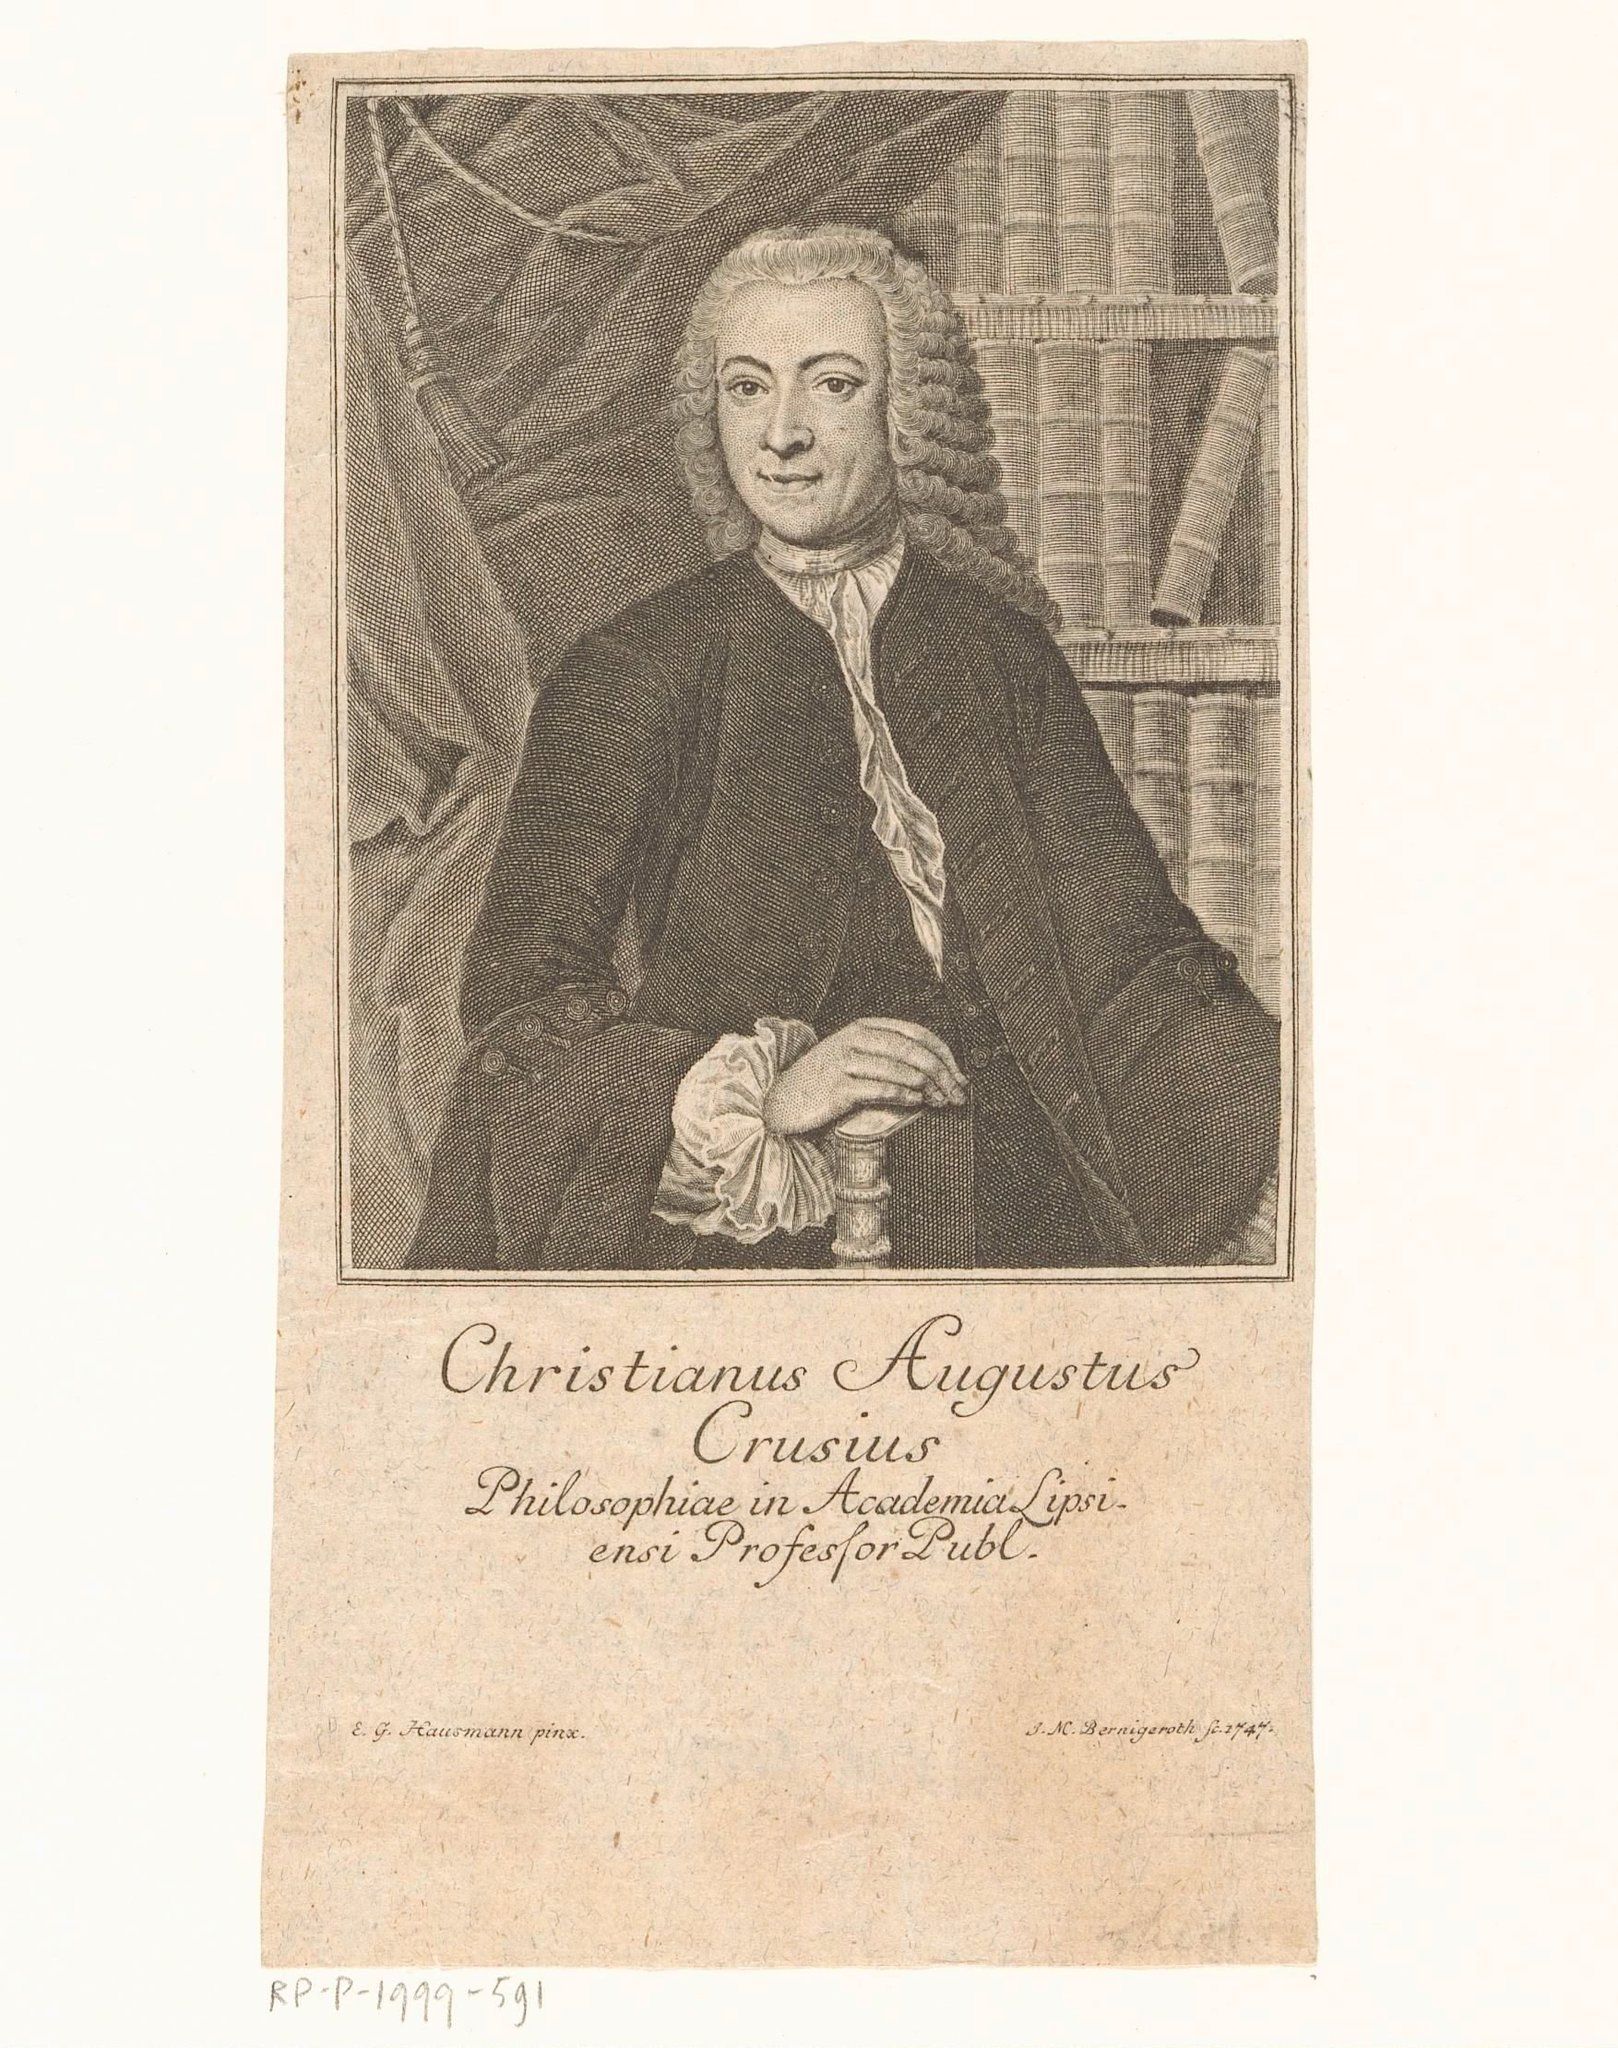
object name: print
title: Portret van Christian August Crusius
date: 1747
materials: paper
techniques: engraving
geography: leipzig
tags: bookshelves, historical persons, book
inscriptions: collector's mark: Lugt 2760, collector's mark: Lugt 2228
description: Prent ook gebruikt in: Zuverlässige Nachrichten von dem gegenwärtigen Zustande, Veränderung und Wachsthum der Wissenschaften. dl. 94. Leipzig: Johann Friedrich Gleditsch, 1747.